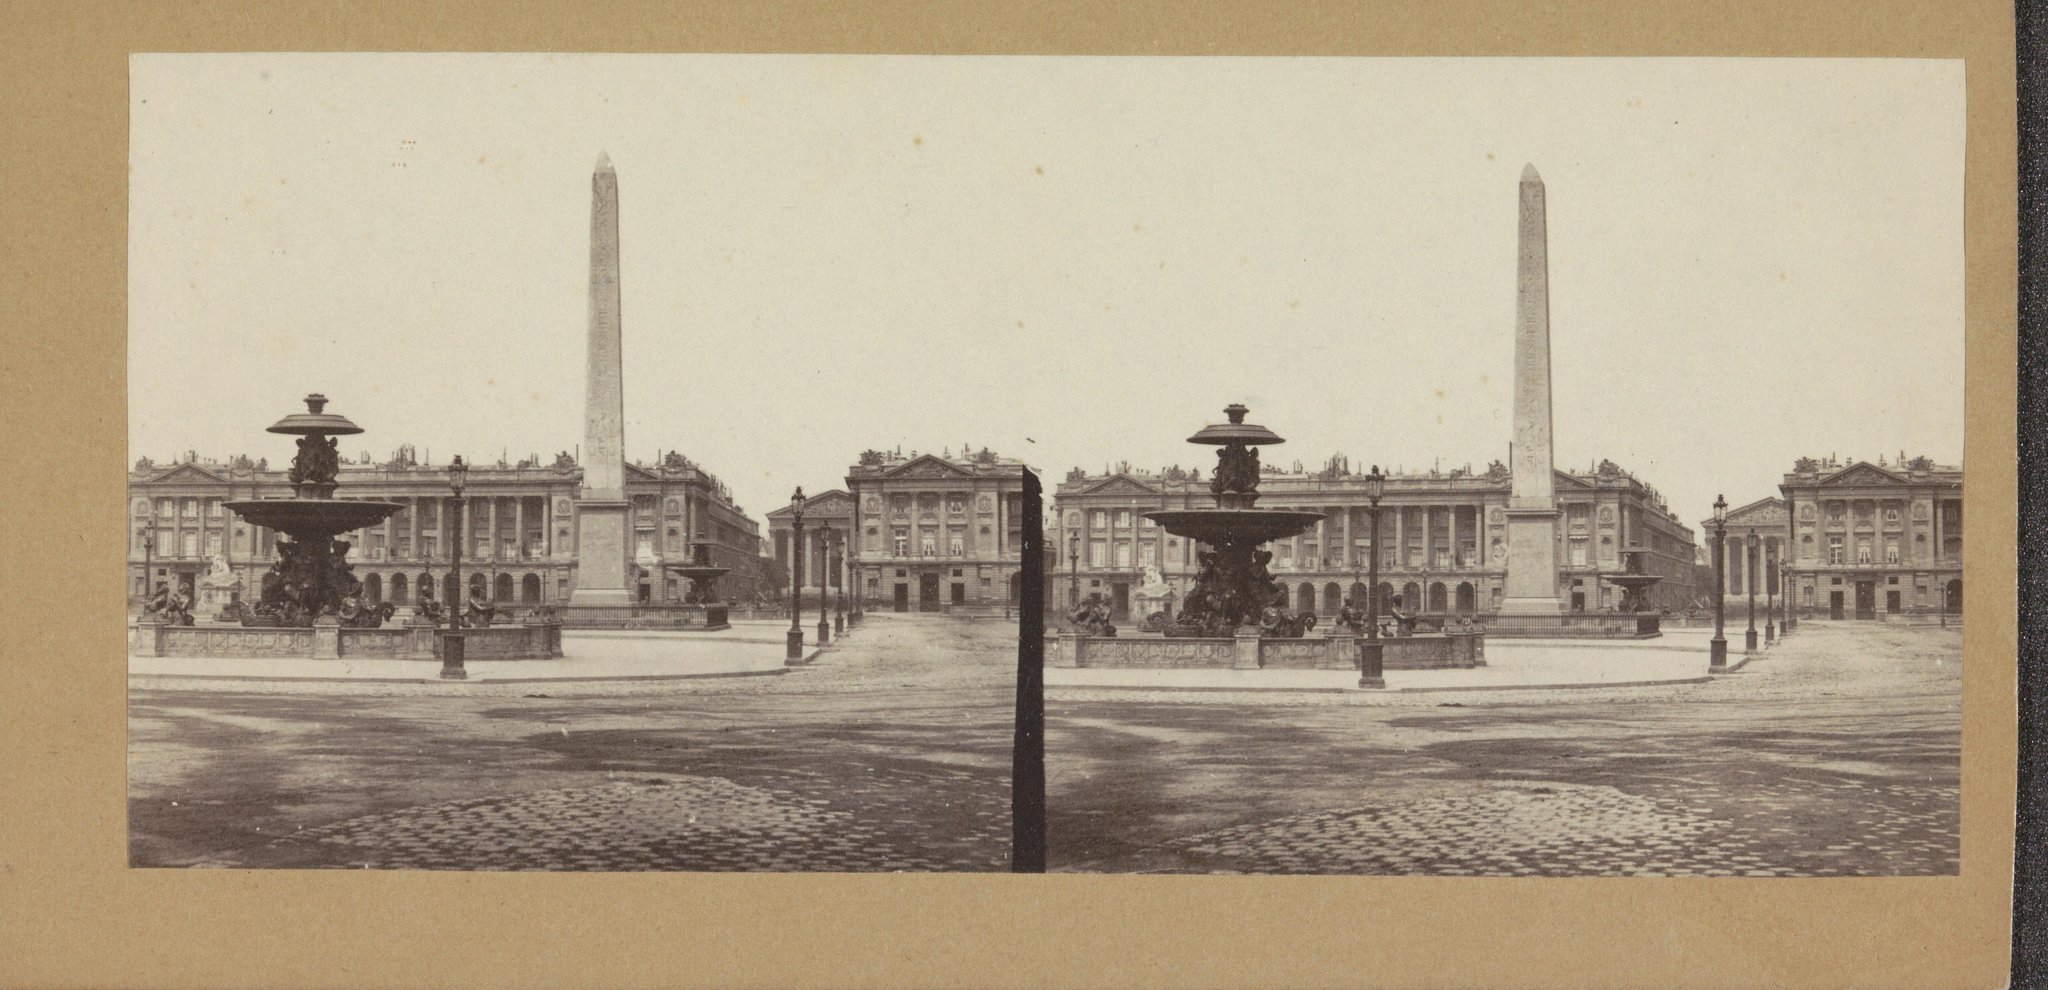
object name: stereograph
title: Place de la Concorde, Parijs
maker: Anonymous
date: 1855-1860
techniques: albumen print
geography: paris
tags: square, place, circus, etc.